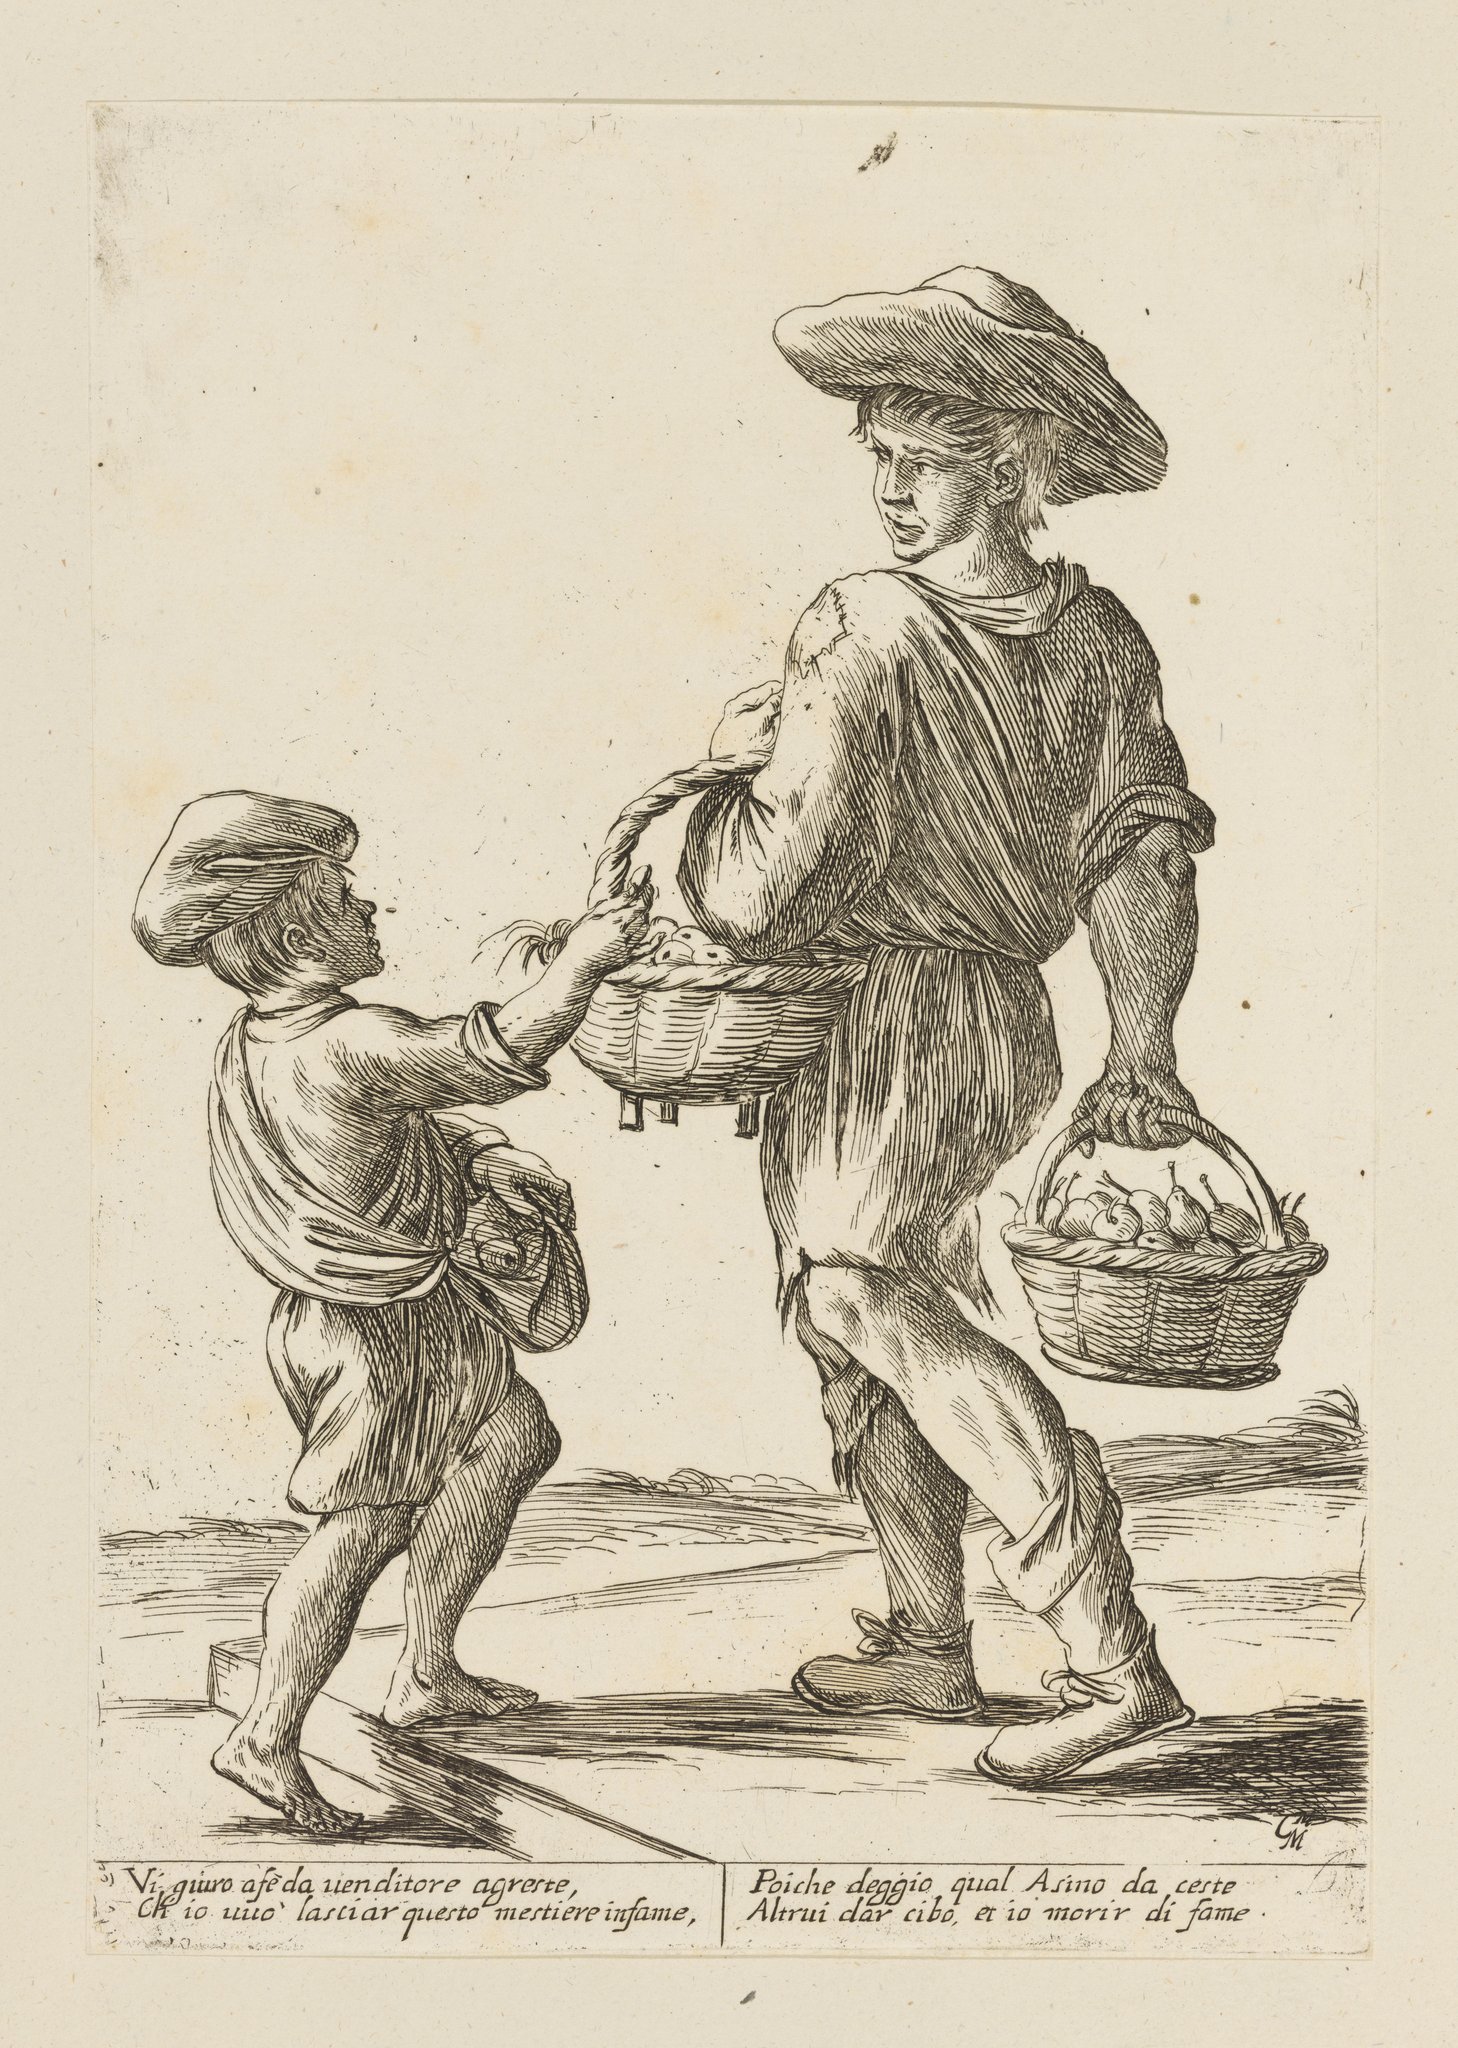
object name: print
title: Fruit Seller, from Di Bologna l'Arti per via D'An.ibal' Ca.rac, plate 22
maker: giuseppe maria mitelli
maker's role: artist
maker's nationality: italian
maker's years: 1634-1718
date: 1660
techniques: etching